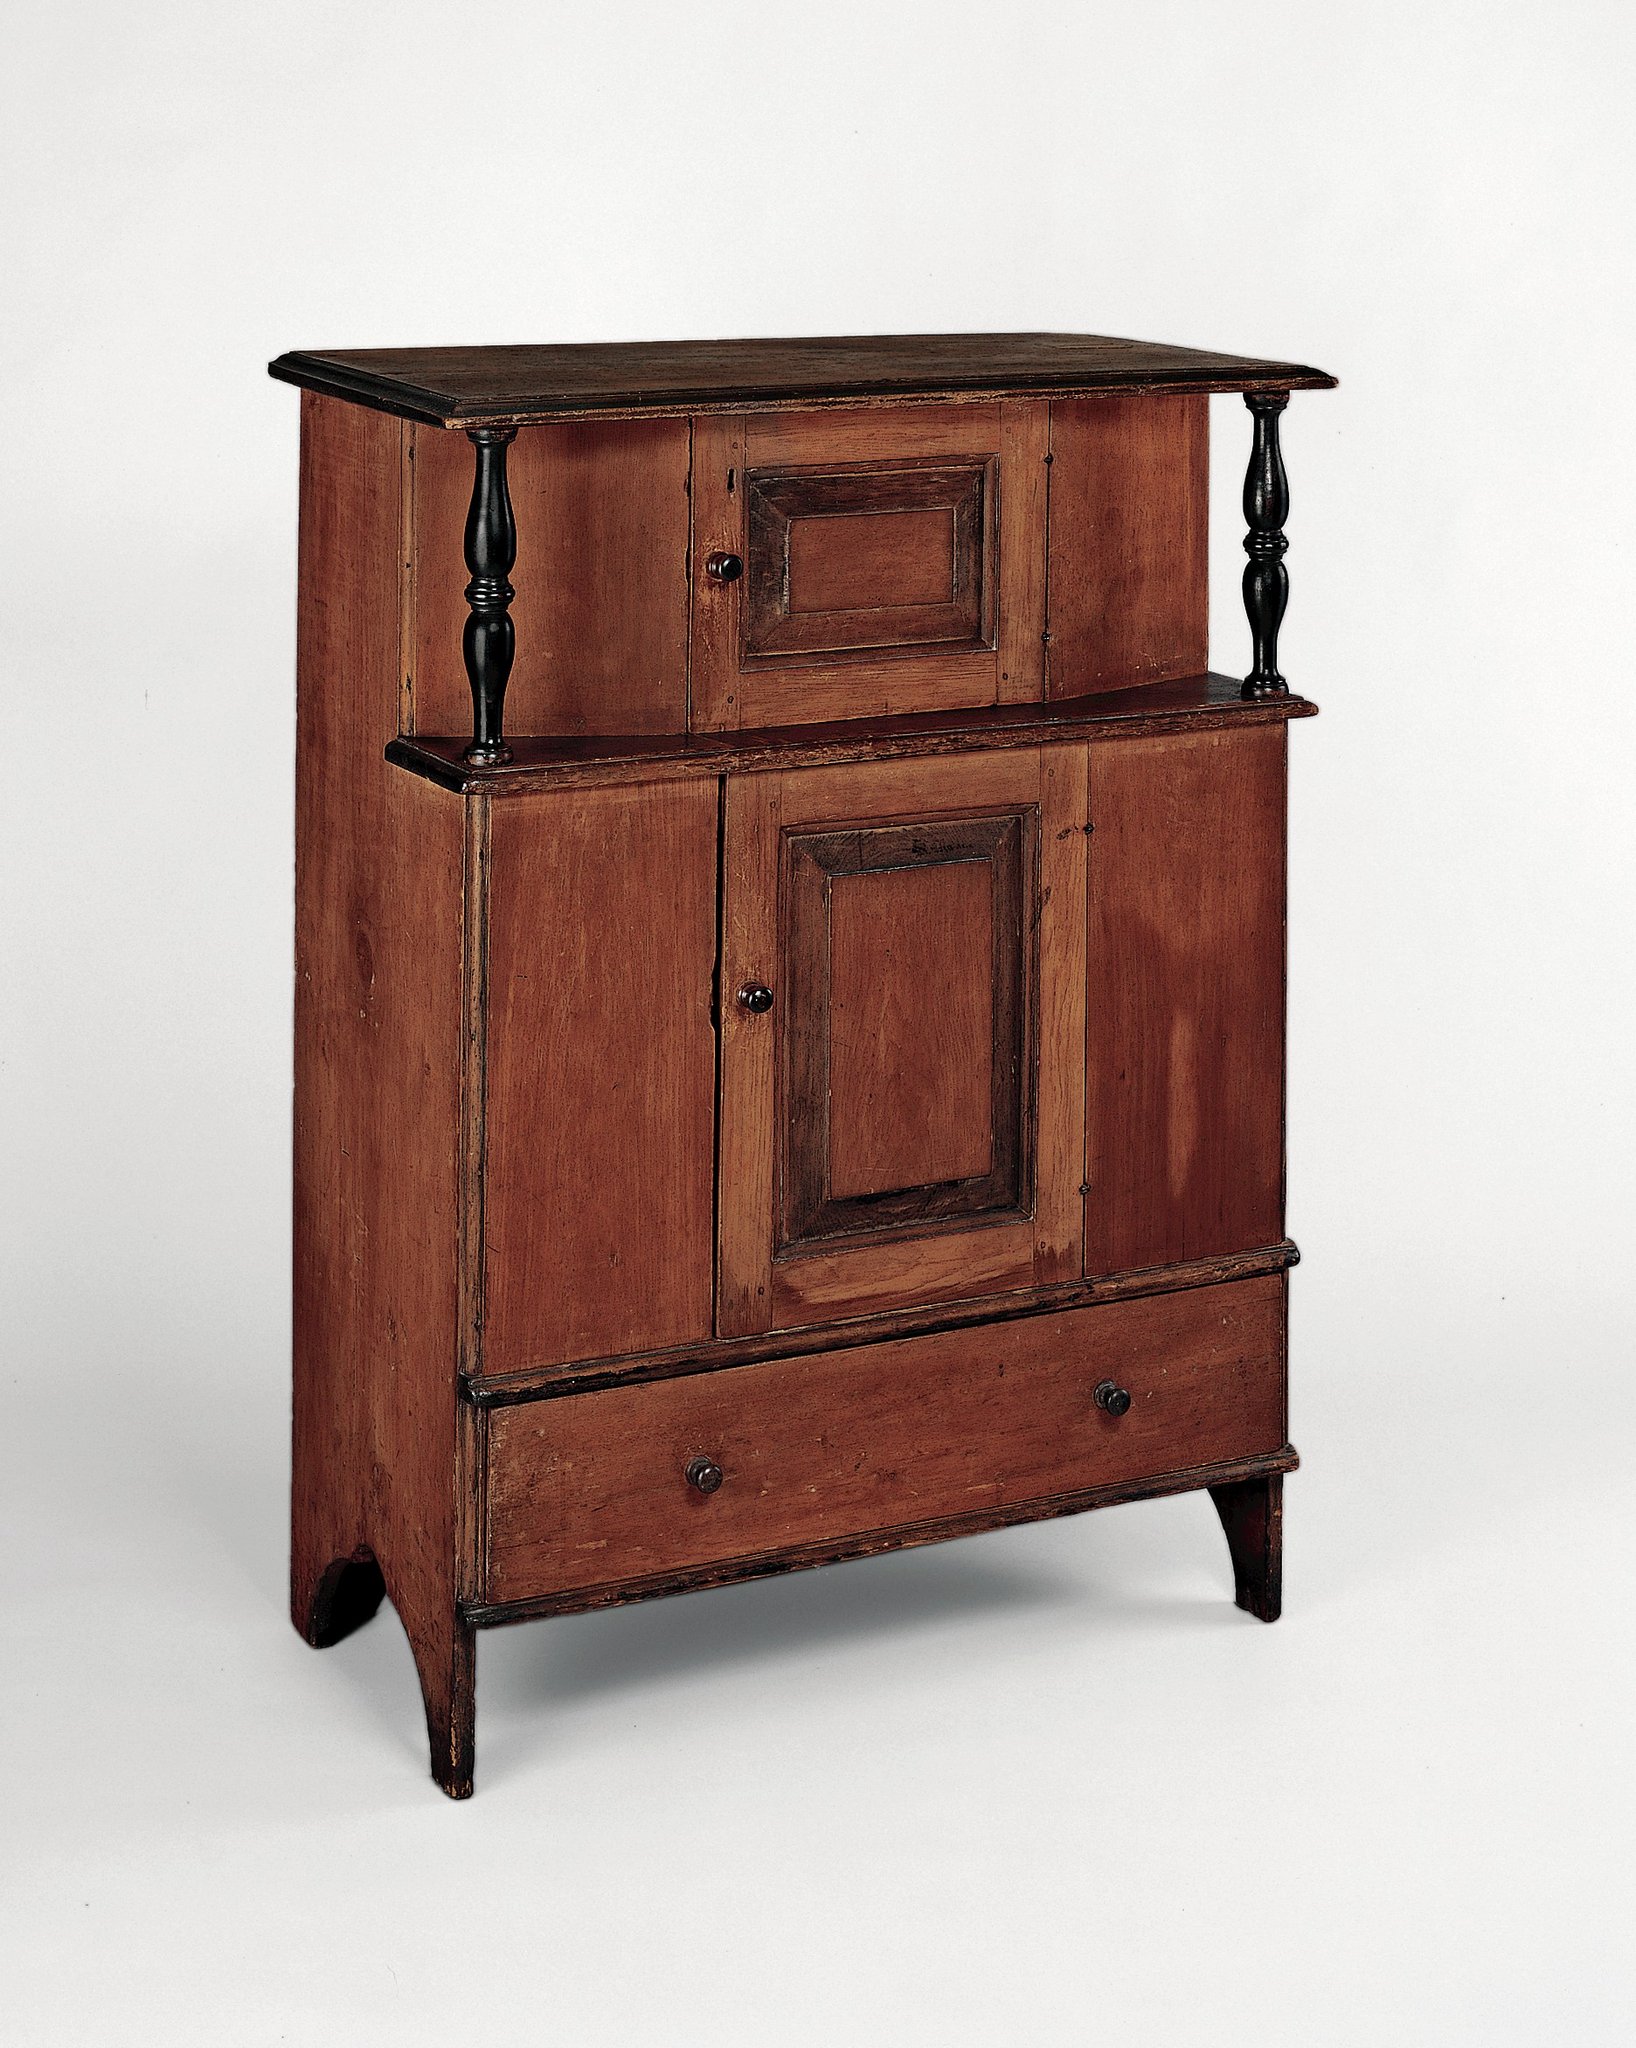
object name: cupboard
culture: american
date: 1710-1750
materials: wood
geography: united states